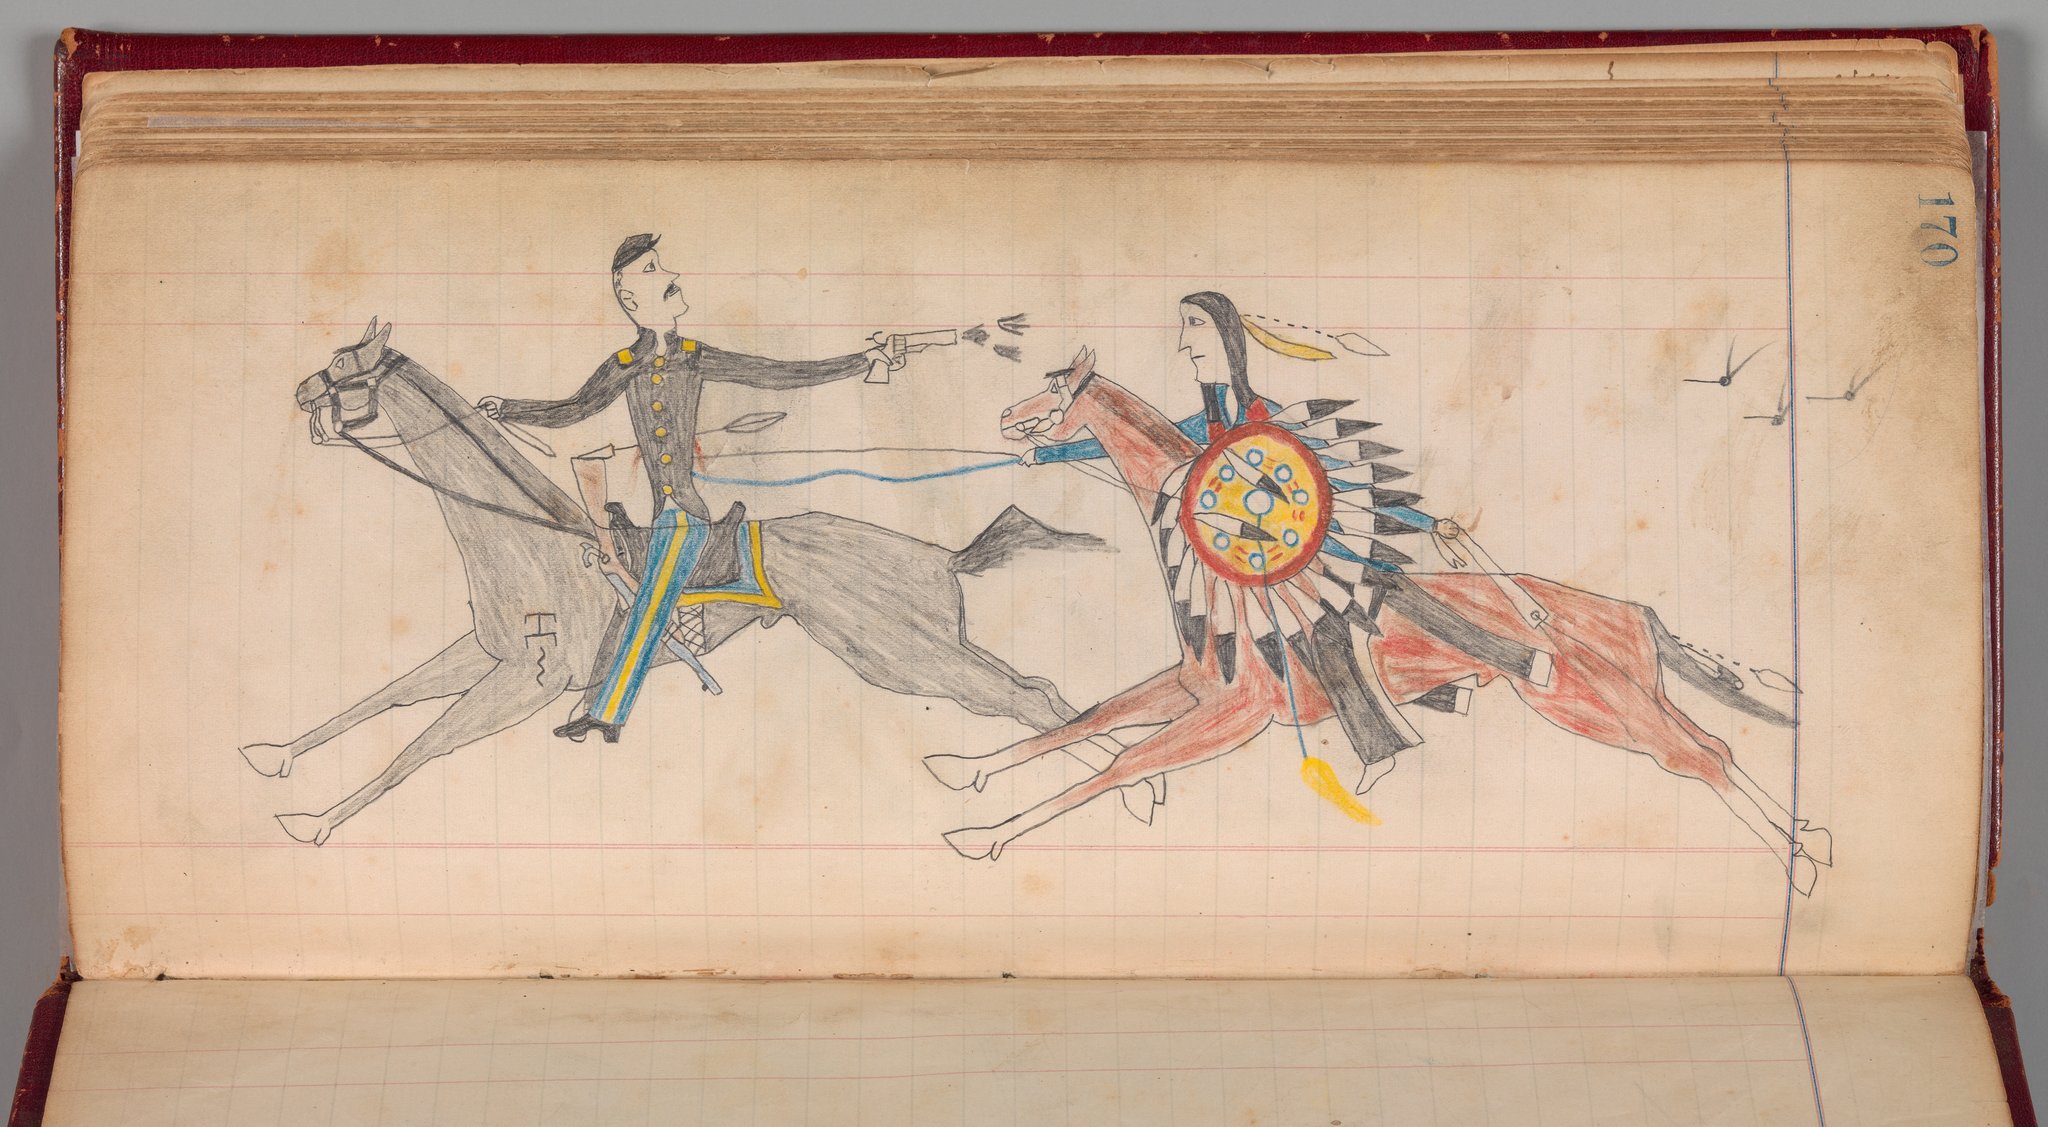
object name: drawing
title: Maffet Ledger: Drawing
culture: cheyenne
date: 1874-1881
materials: crayon, graphite, paper, watercolor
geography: united states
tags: men,women,horses